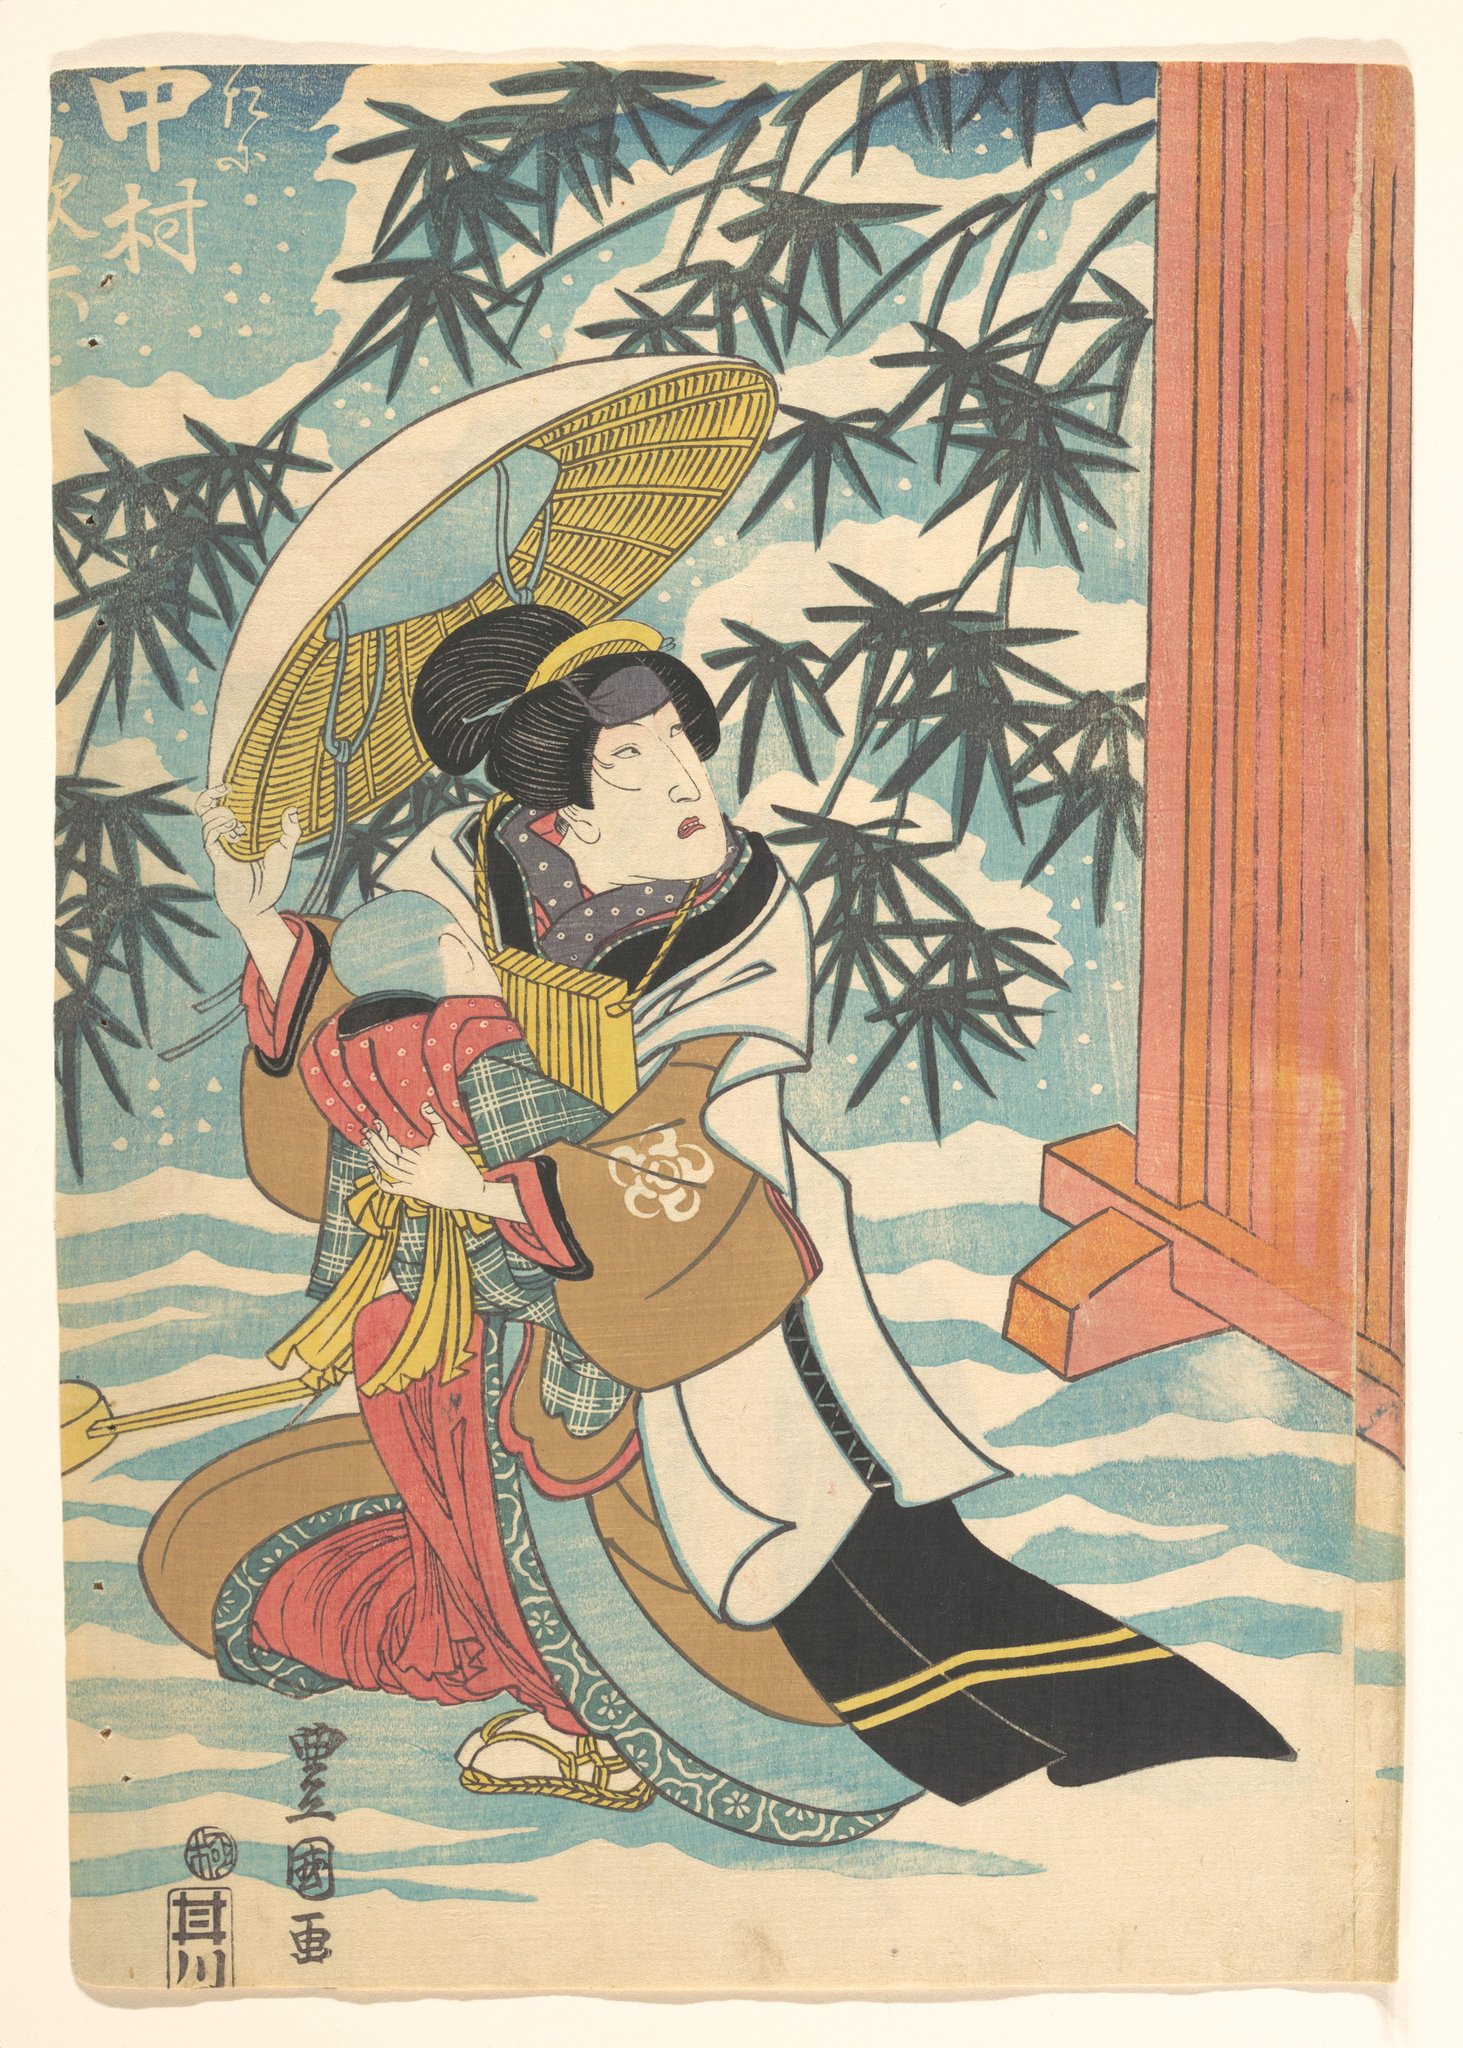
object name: print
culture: japanese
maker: utagawa kunisada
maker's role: artist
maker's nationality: japanese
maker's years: 1786-1864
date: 1801-1900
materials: ink, paper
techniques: woodblock print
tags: infants,mothers,trees,snow